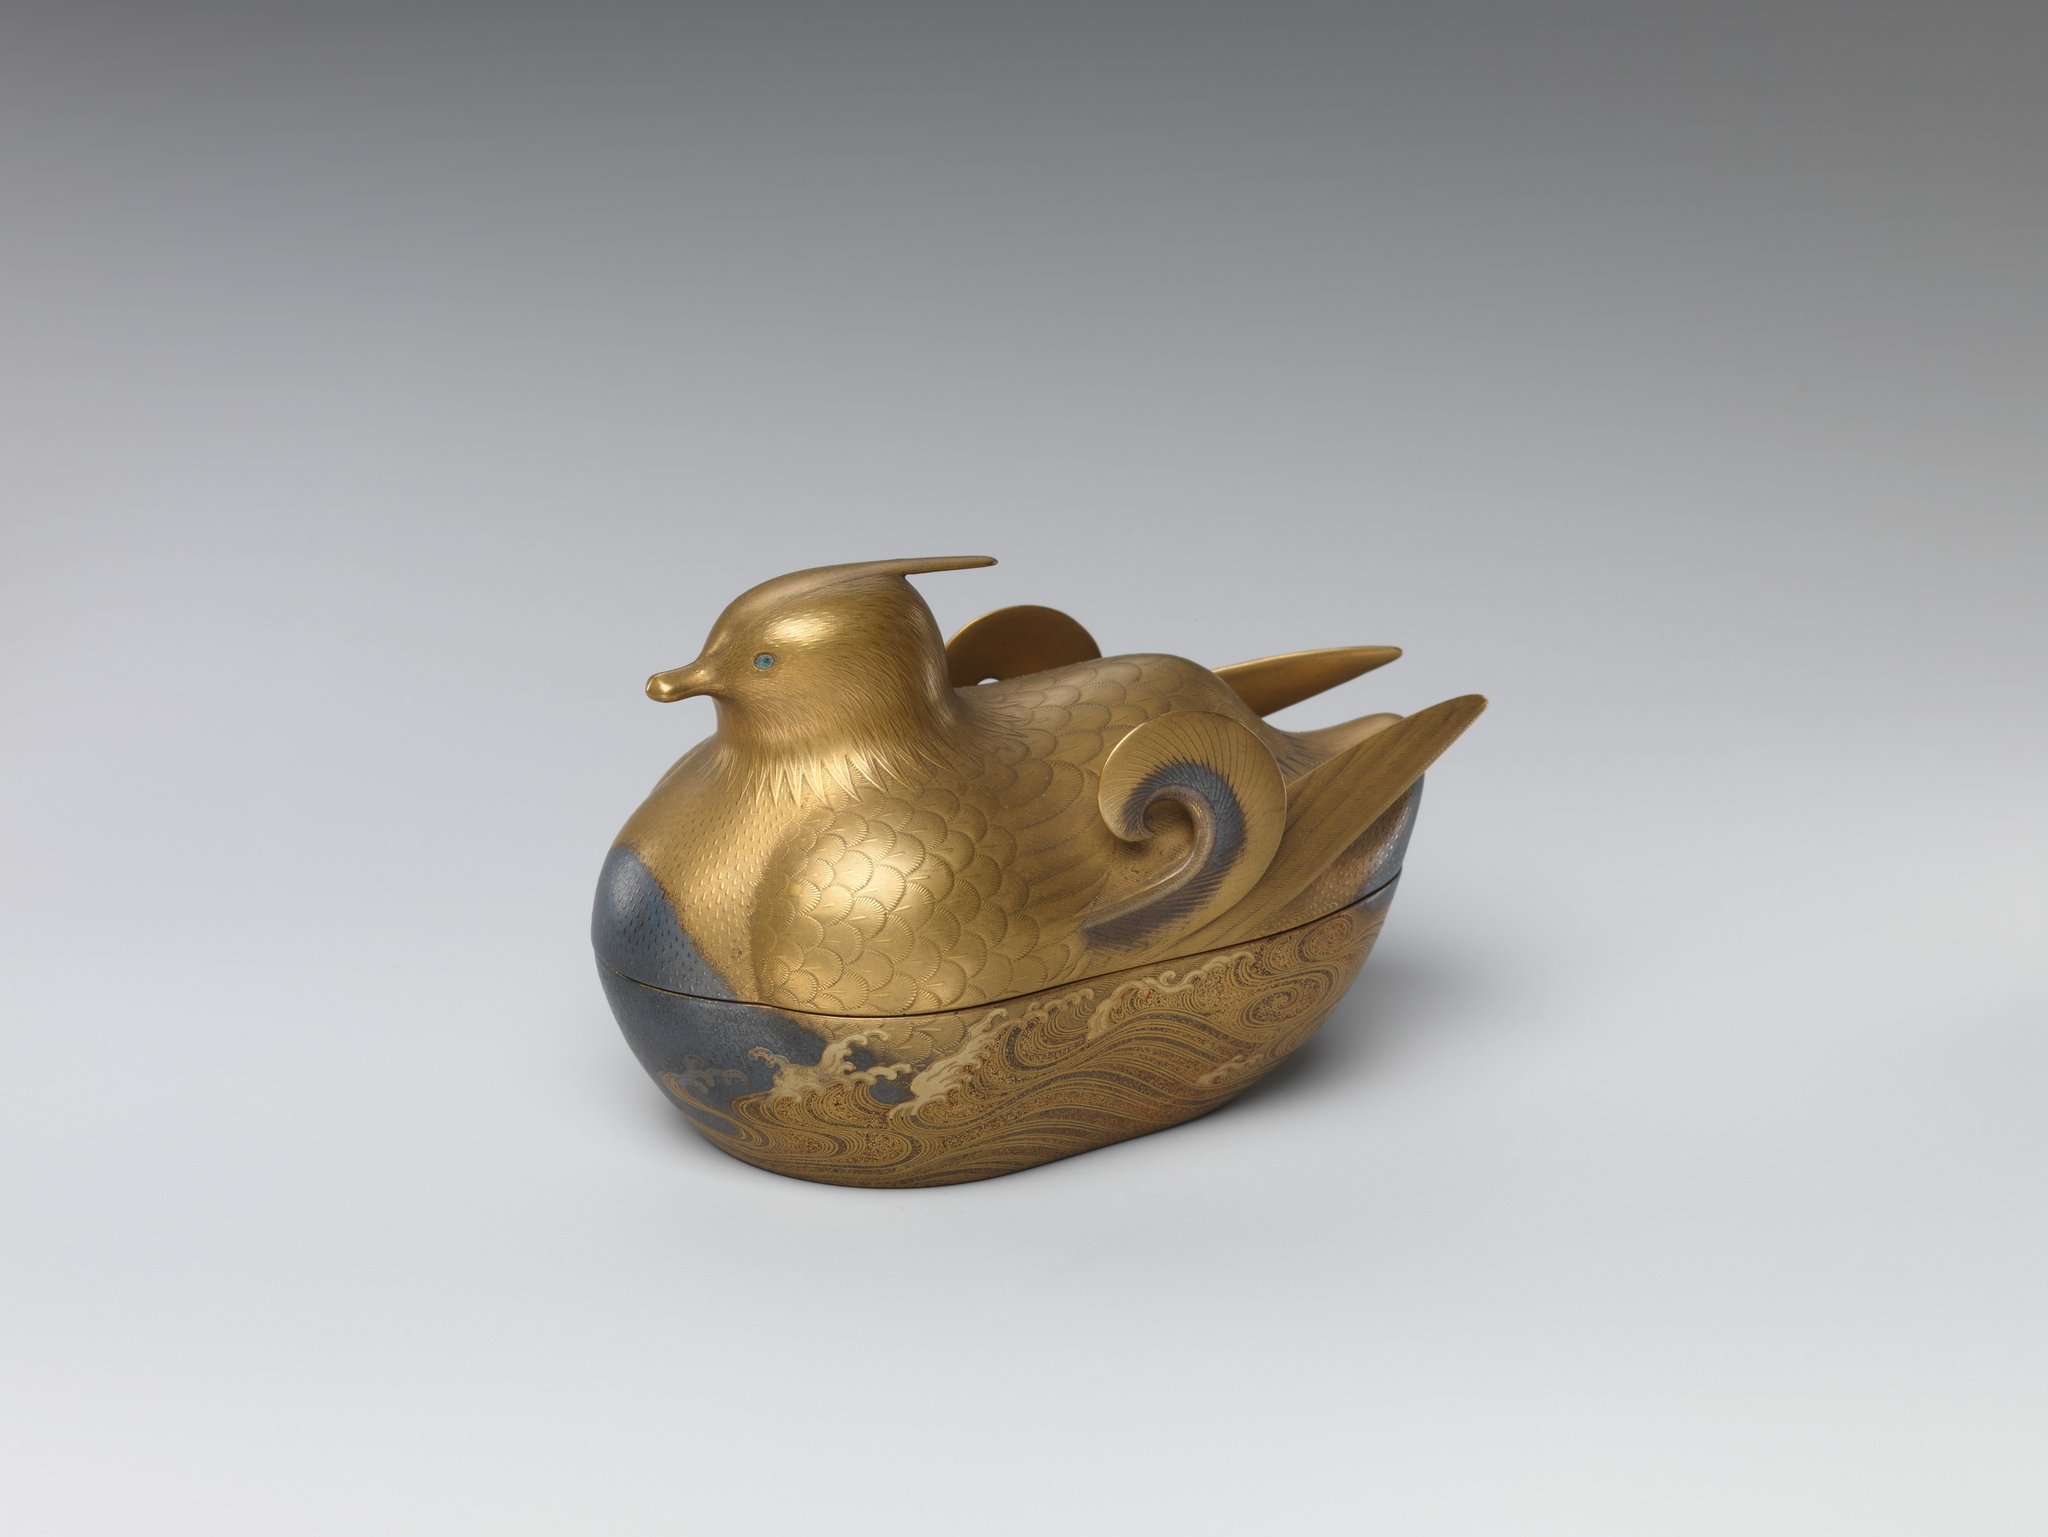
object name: incense box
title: Incense Box in Shape of Mandarin Duck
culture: japanese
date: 1701-1800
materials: gold, lacquer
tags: ducks